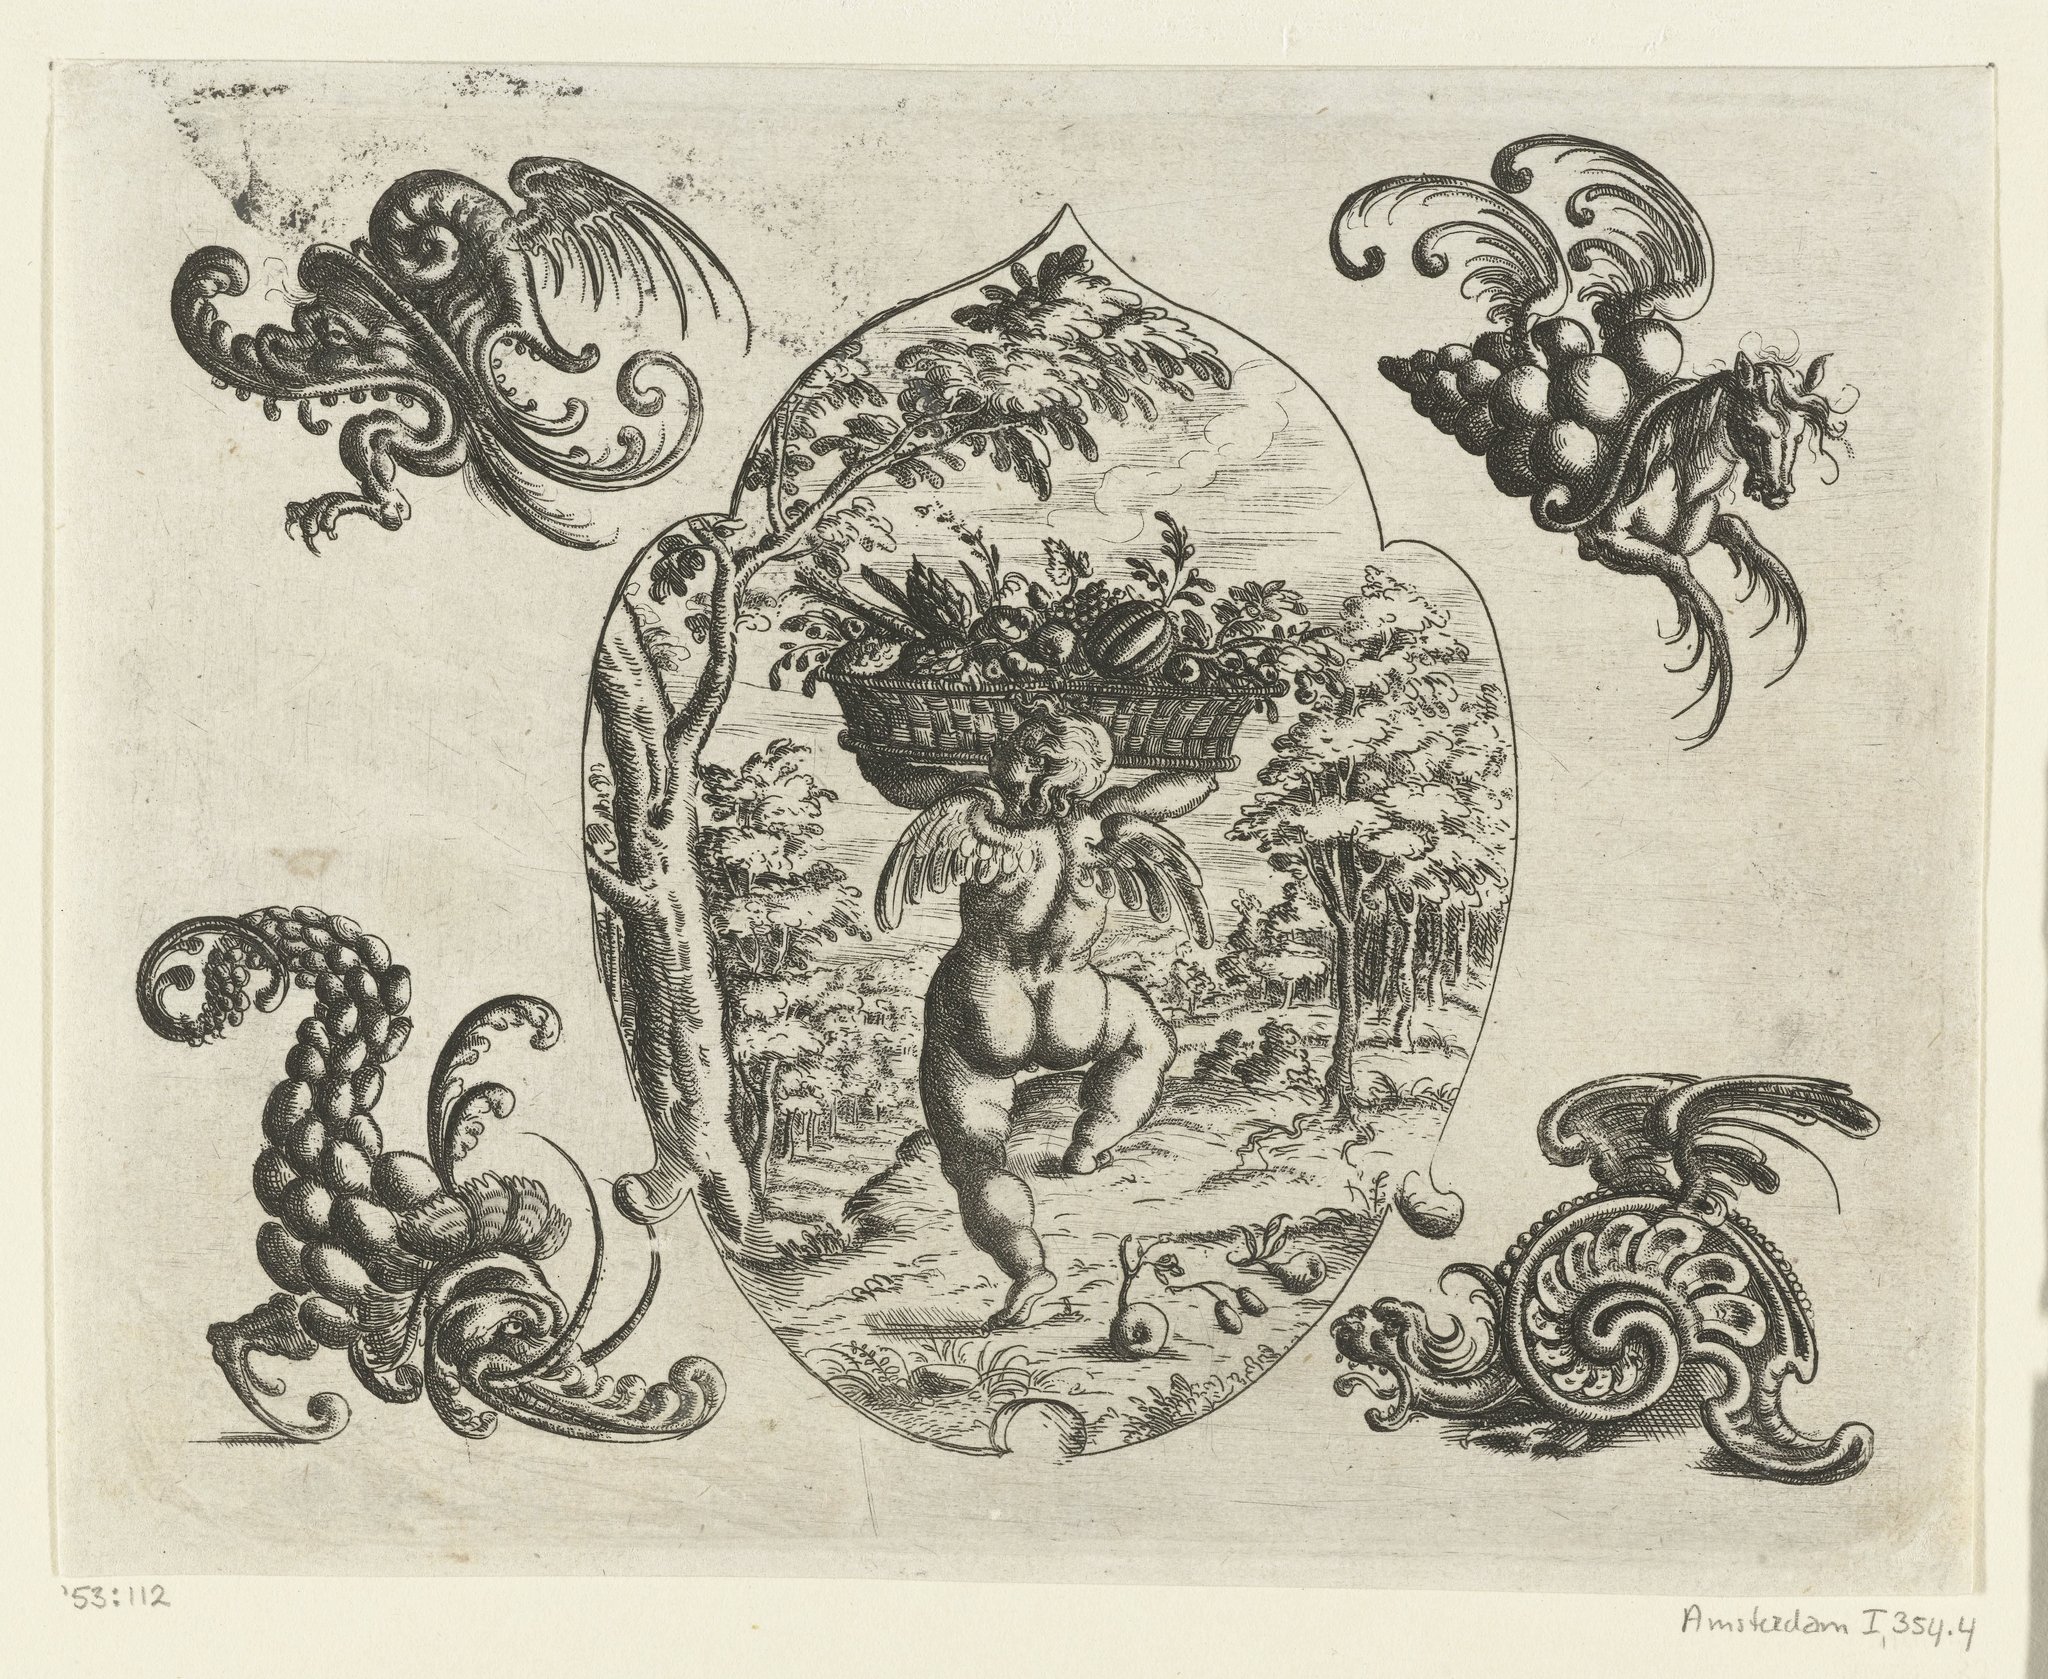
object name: ornament print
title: Bladvormig ornament met een putto die een grote mand vruchten draagt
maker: christoph jamnitzer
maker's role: draughtsman, goldsmith, print maker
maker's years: 1563-1618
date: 1573-1610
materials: paper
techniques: etching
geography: germany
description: Blad uit een serie vlakdecoraties met grotesken, cartouches, ovalen, mascarons, putti en fantastische wezens. De serie bestaat uit drie titelbladen, twee tekstbladen met de opdracht en het voorwoord en 60 bladen, verdeeld over drie boeken.